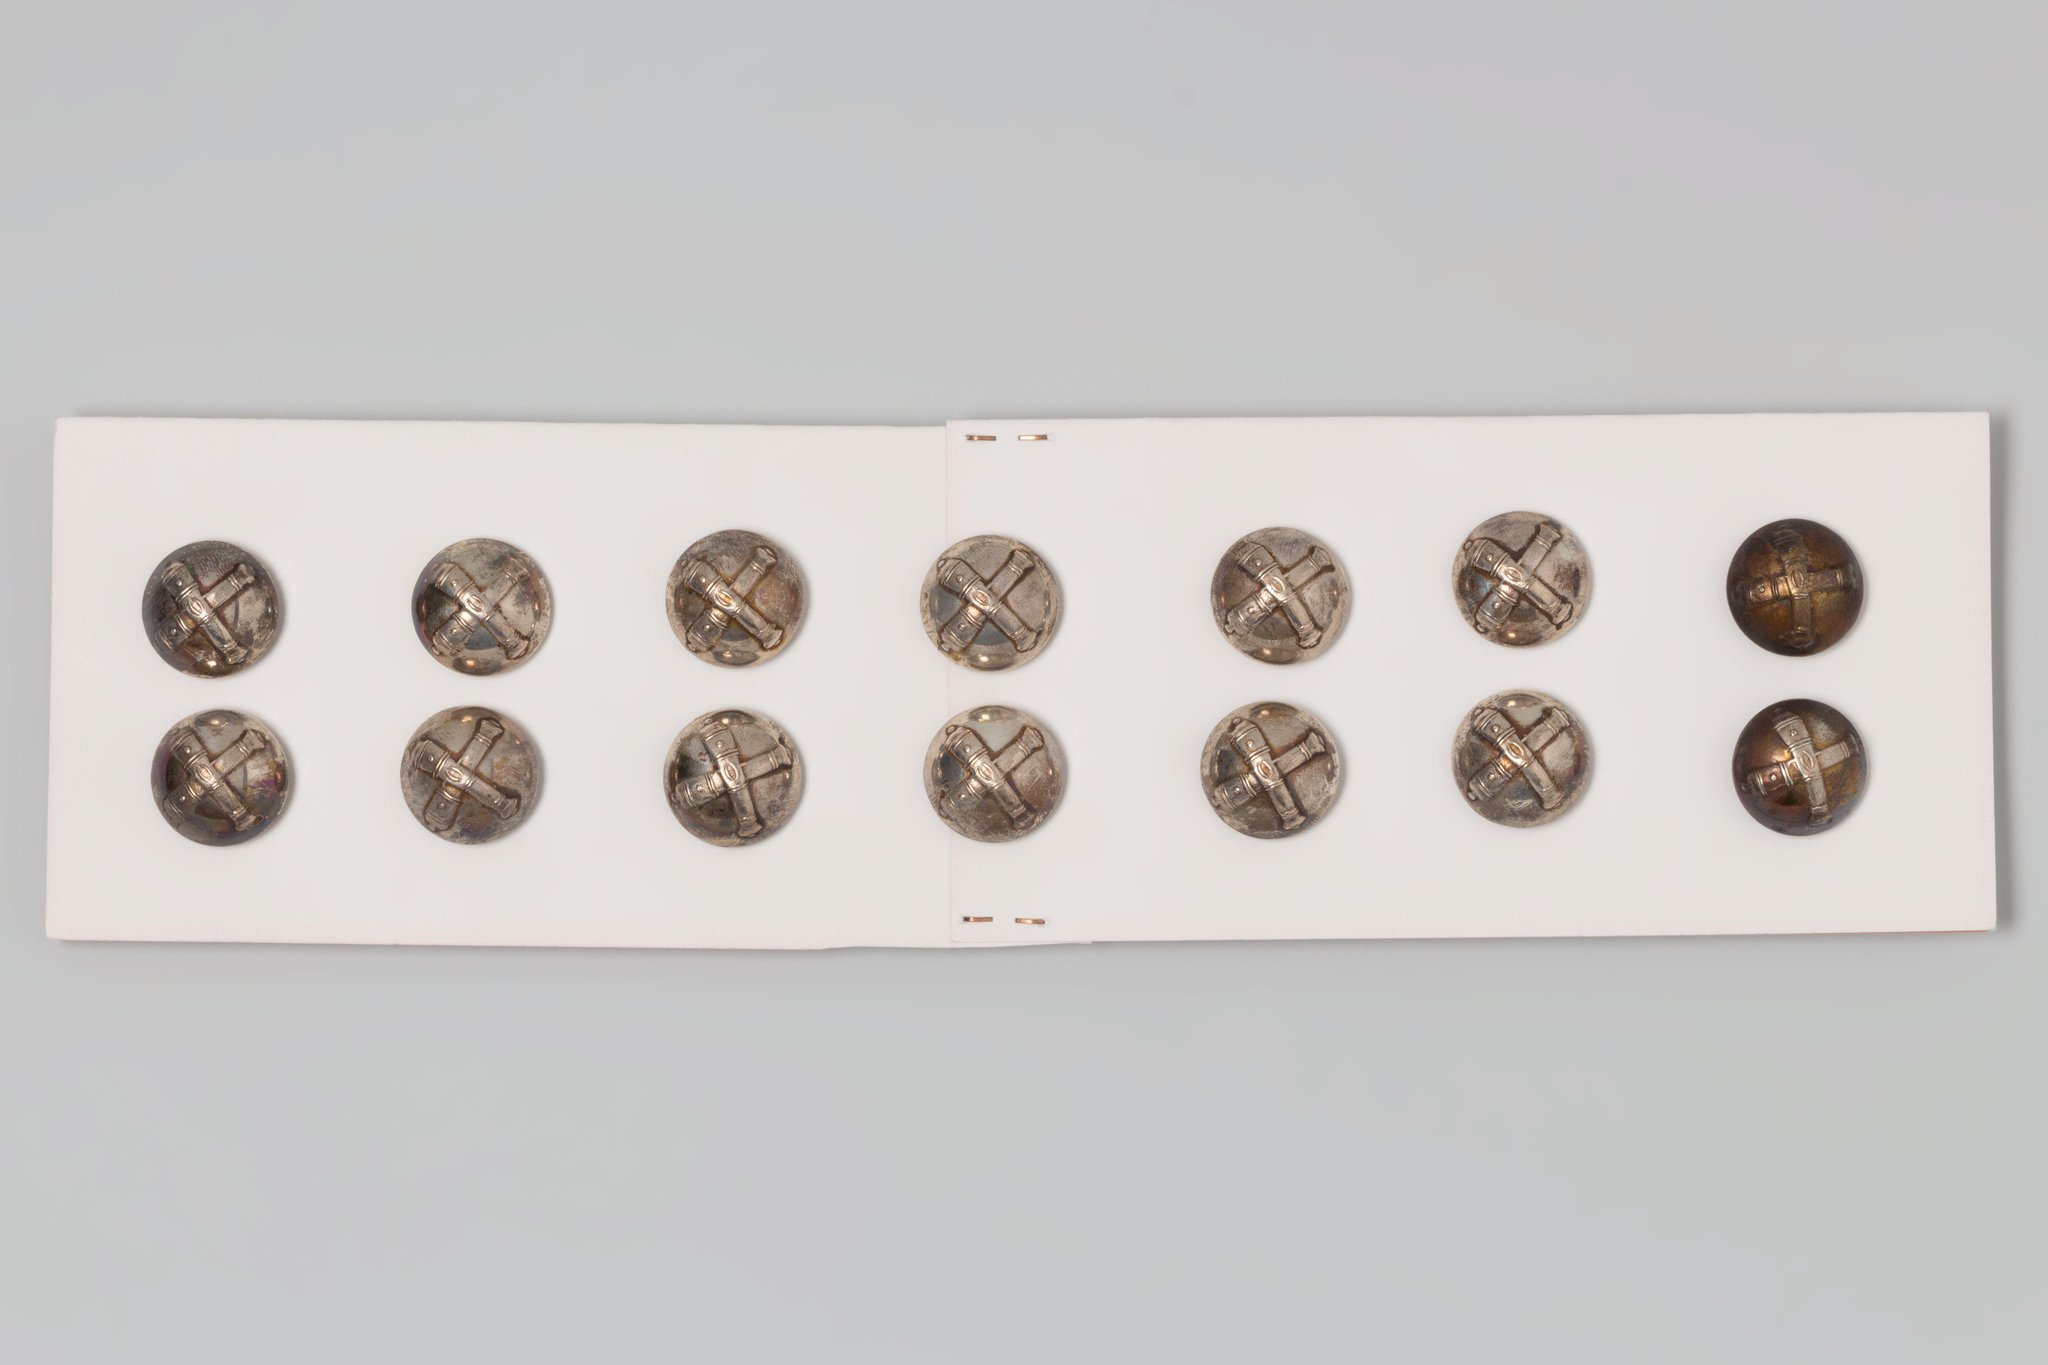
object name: menswear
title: Bolvormige knoop van verzilverd koper, waarop twee gekruiste kanonnen in reliëf; onderdeel van een artillerie-uniform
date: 1885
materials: copper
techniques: silvering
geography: the hague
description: Geborgen in een doos bij een sjerp; notitie in doos: "W. Six 1859-1928/14 knoopen schutterij uniform/1885".